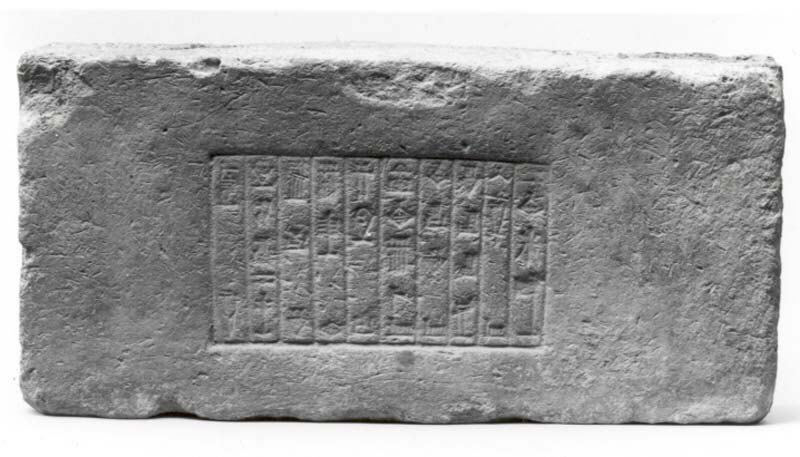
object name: brick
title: Inscribed brick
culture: babylonian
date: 2000-1901 BCE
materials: ceramic, glaze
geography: mesopotamia